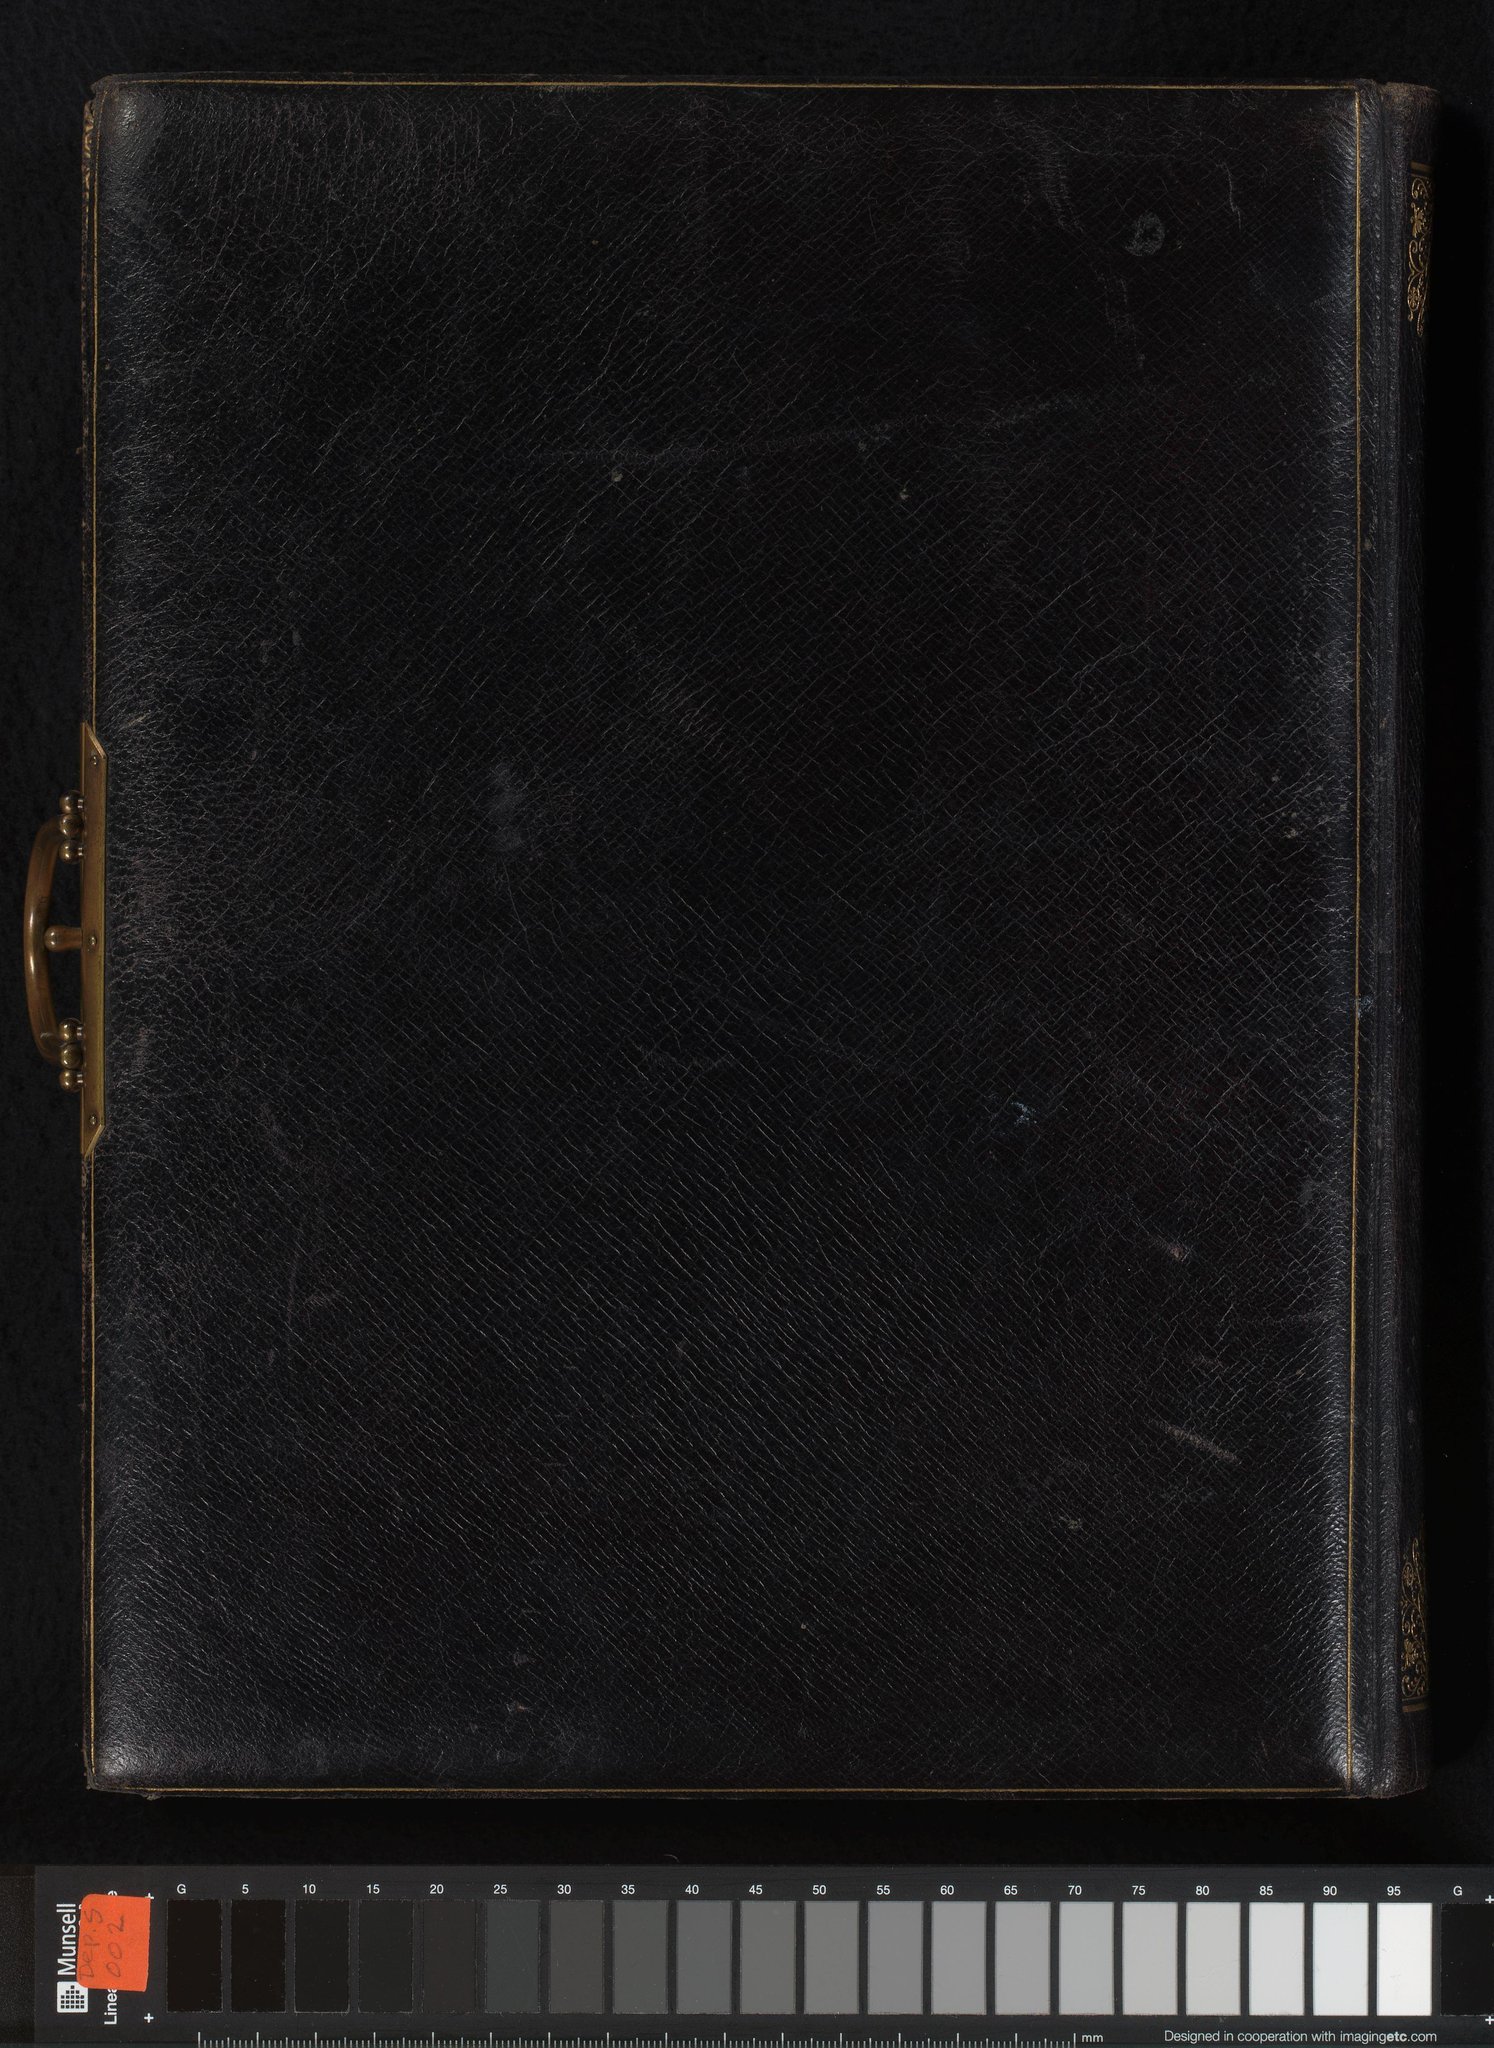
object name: photograph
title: Portret van een staande man in uniform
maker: e. hooper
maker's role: fotograaf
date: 1785-1870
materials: cardboard, paper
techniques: albumen print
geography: devon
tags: adult man, historical persons, (military) uniforms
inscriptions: inscription: ‘Photographed/ BY/ E. HOOPER/ 3/ UNION ST./ STONEHOUSE/ (DEVON)’